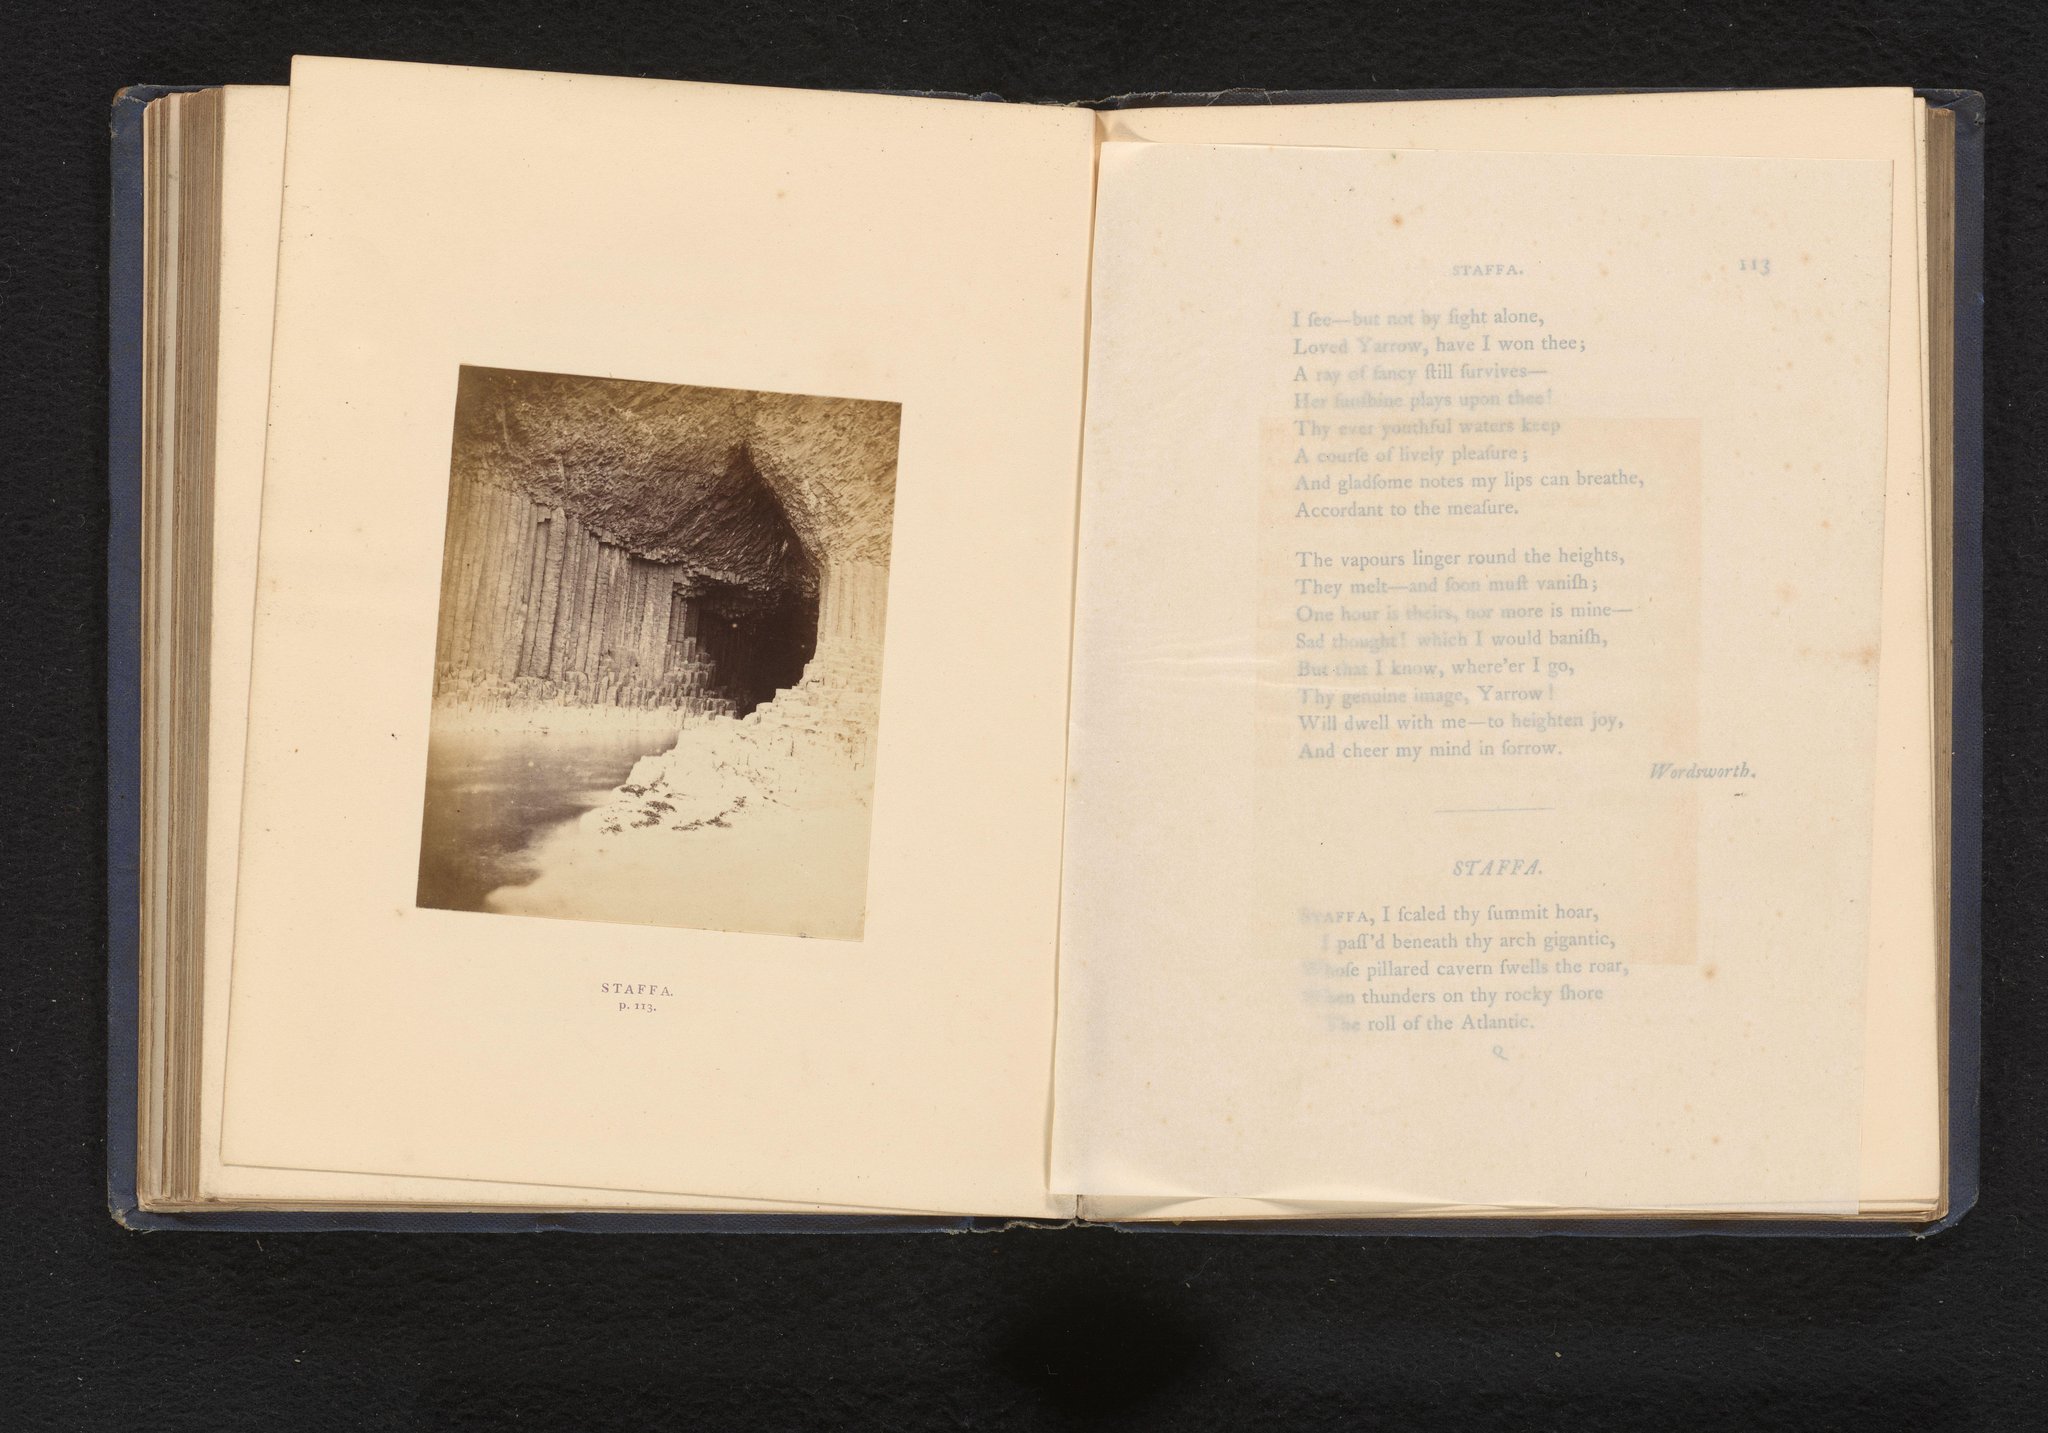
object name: page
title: Fingal's Cave te Staffa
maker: stephen thompson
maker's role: fotograaf, schrijver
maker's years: 1831-1893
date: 1863-1868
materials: paper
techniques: albumen print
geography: staffa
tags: cave, grotto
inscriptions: inscription: ‘p. 113.’